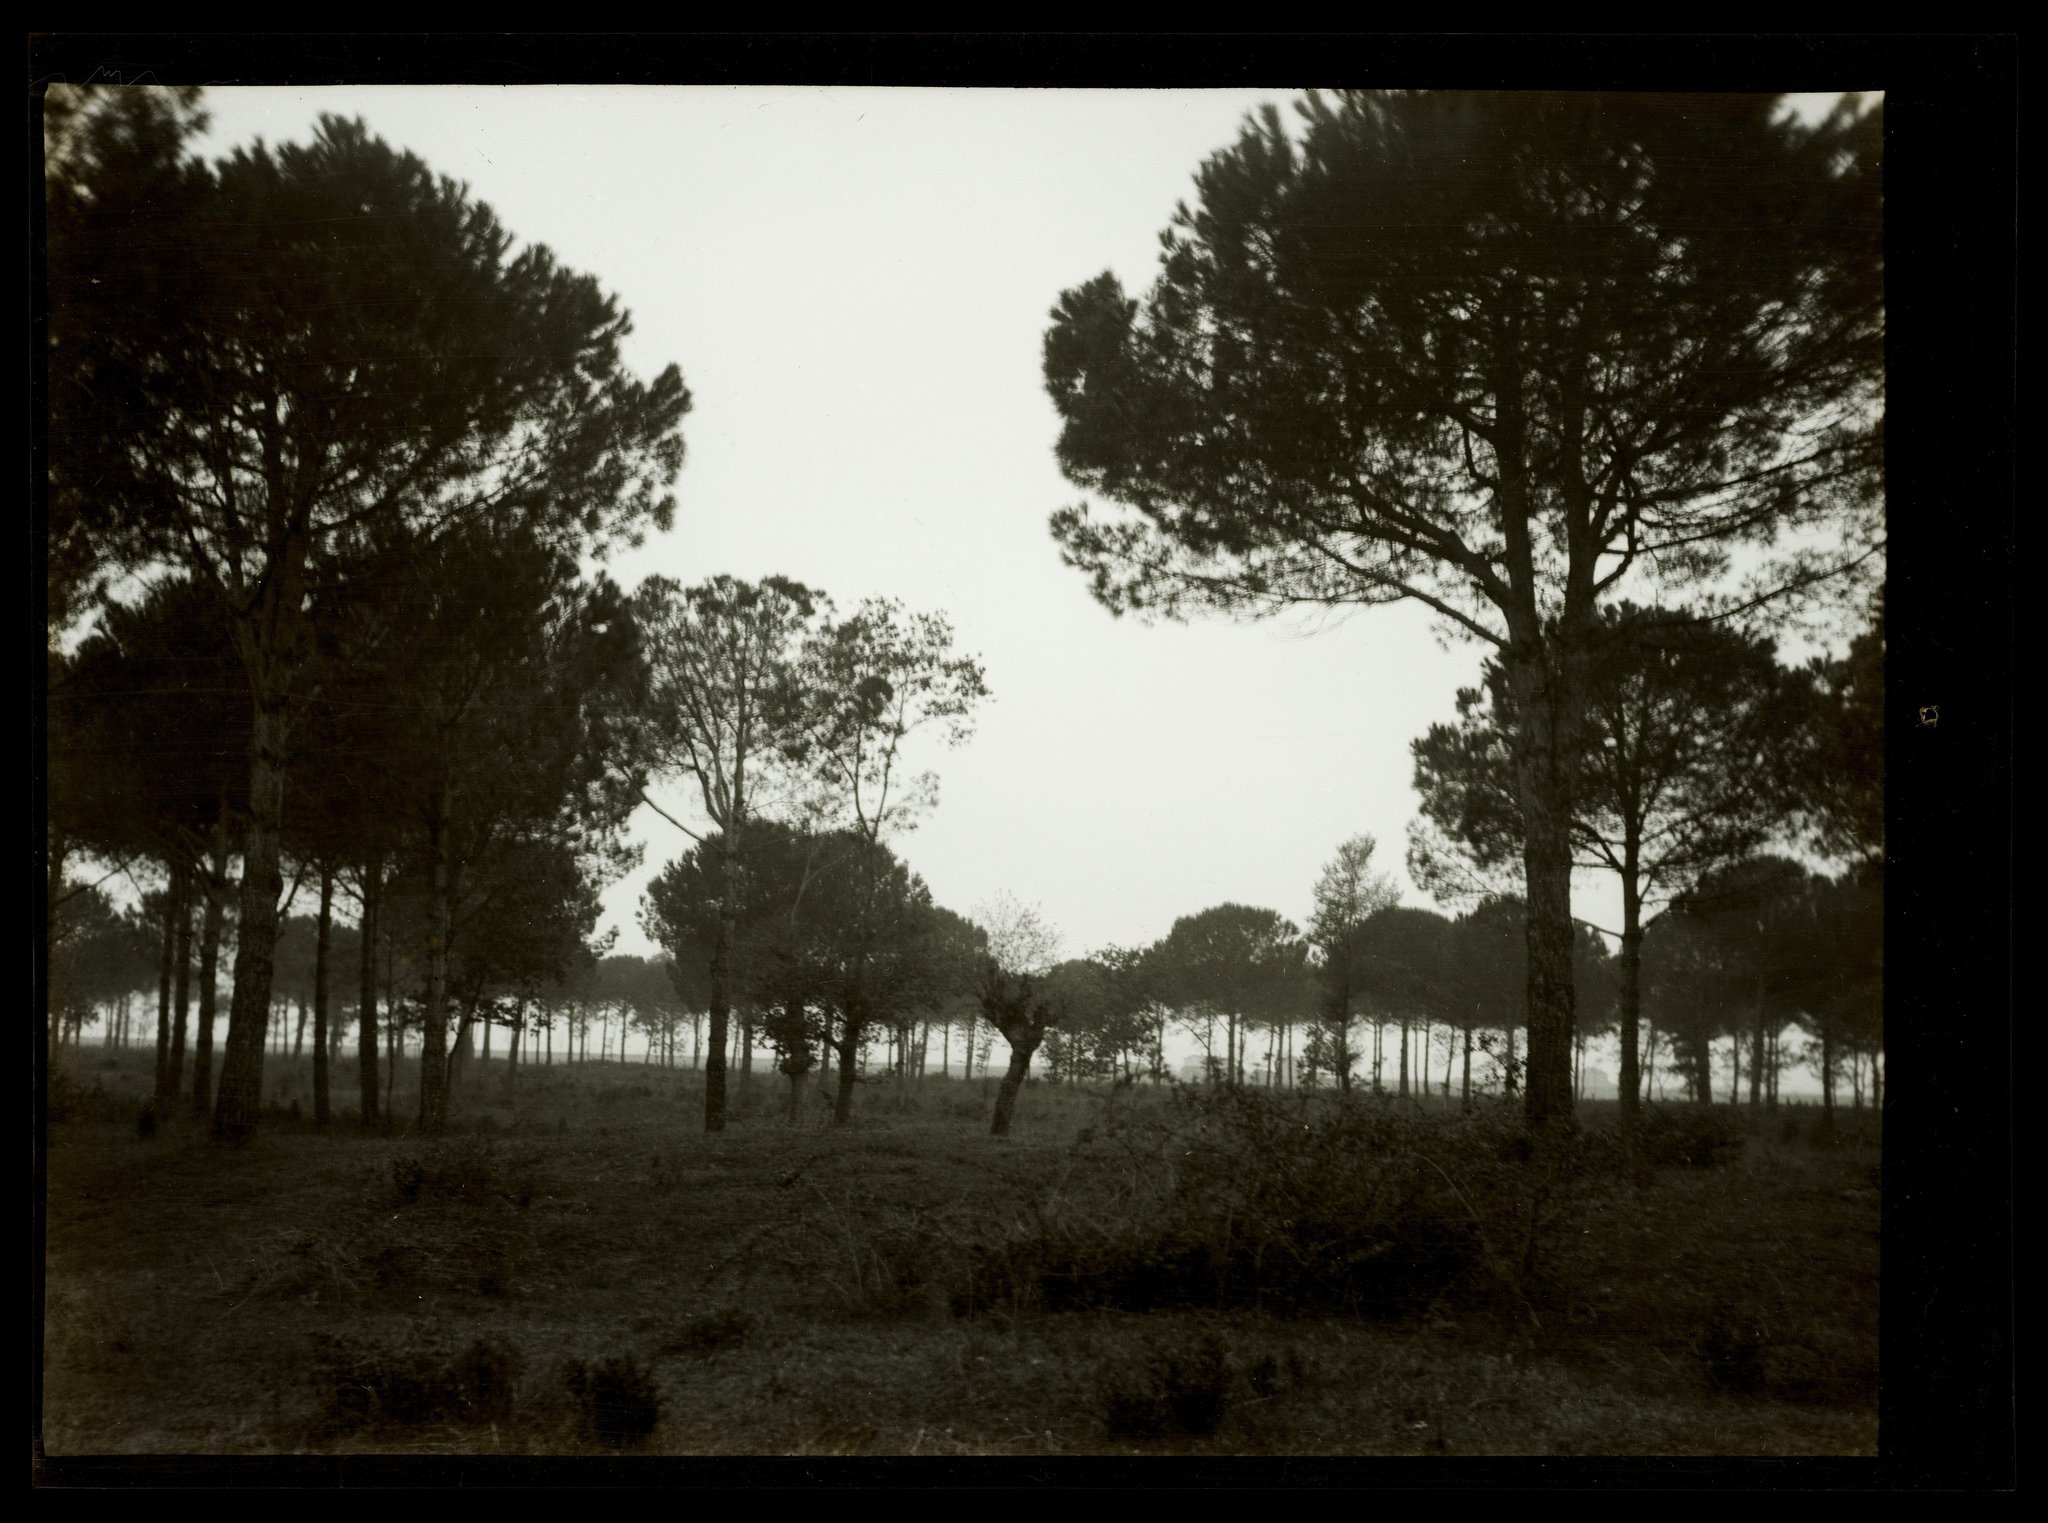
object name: photograph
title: Filmnegatief met opname van Genua, Pisa, Ravenna of Milaan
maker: Anonymous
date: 1907-1935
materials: film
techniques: gelatin silver negative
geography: italy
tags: italy